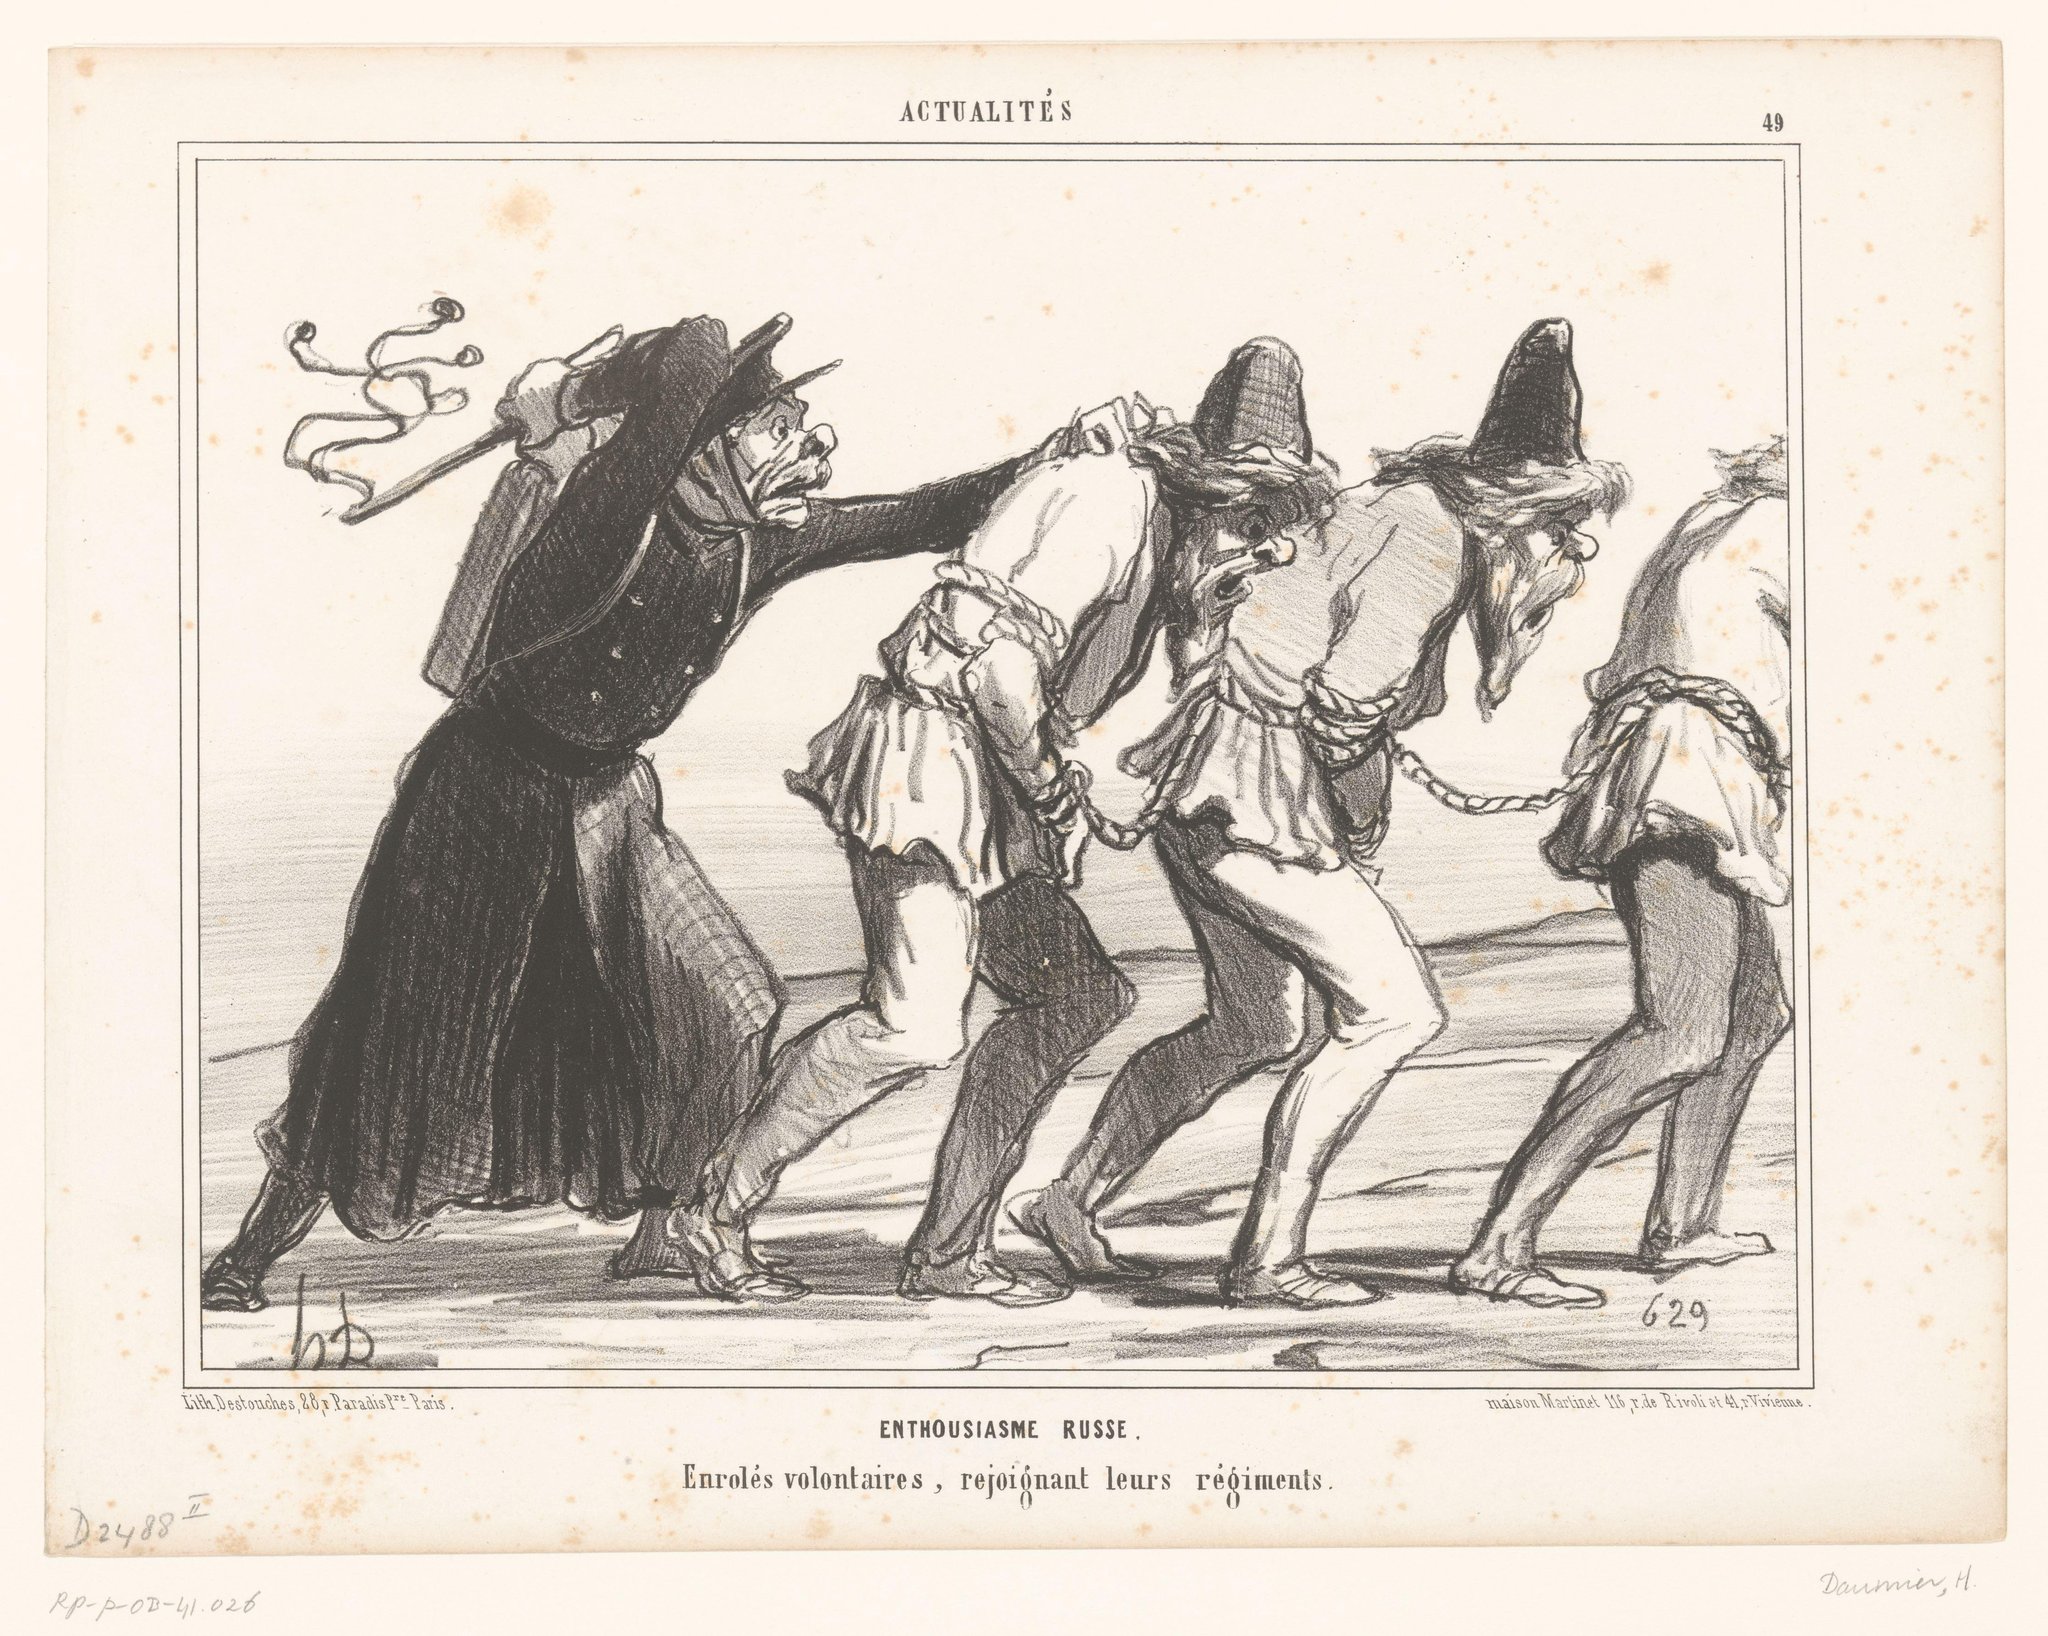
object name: cartoon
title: Karikatuur van drie Russische soldaten die door een zweep worden voortgedreven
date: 1854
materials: paper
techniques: lithograph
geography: paris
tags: army 'en route', caricatures (human types), political caricatures and satires, whip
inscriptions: collector's mark: Lugt 2228a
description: Prent gebruikt voor: Le Charivari, 23 mei 1854.